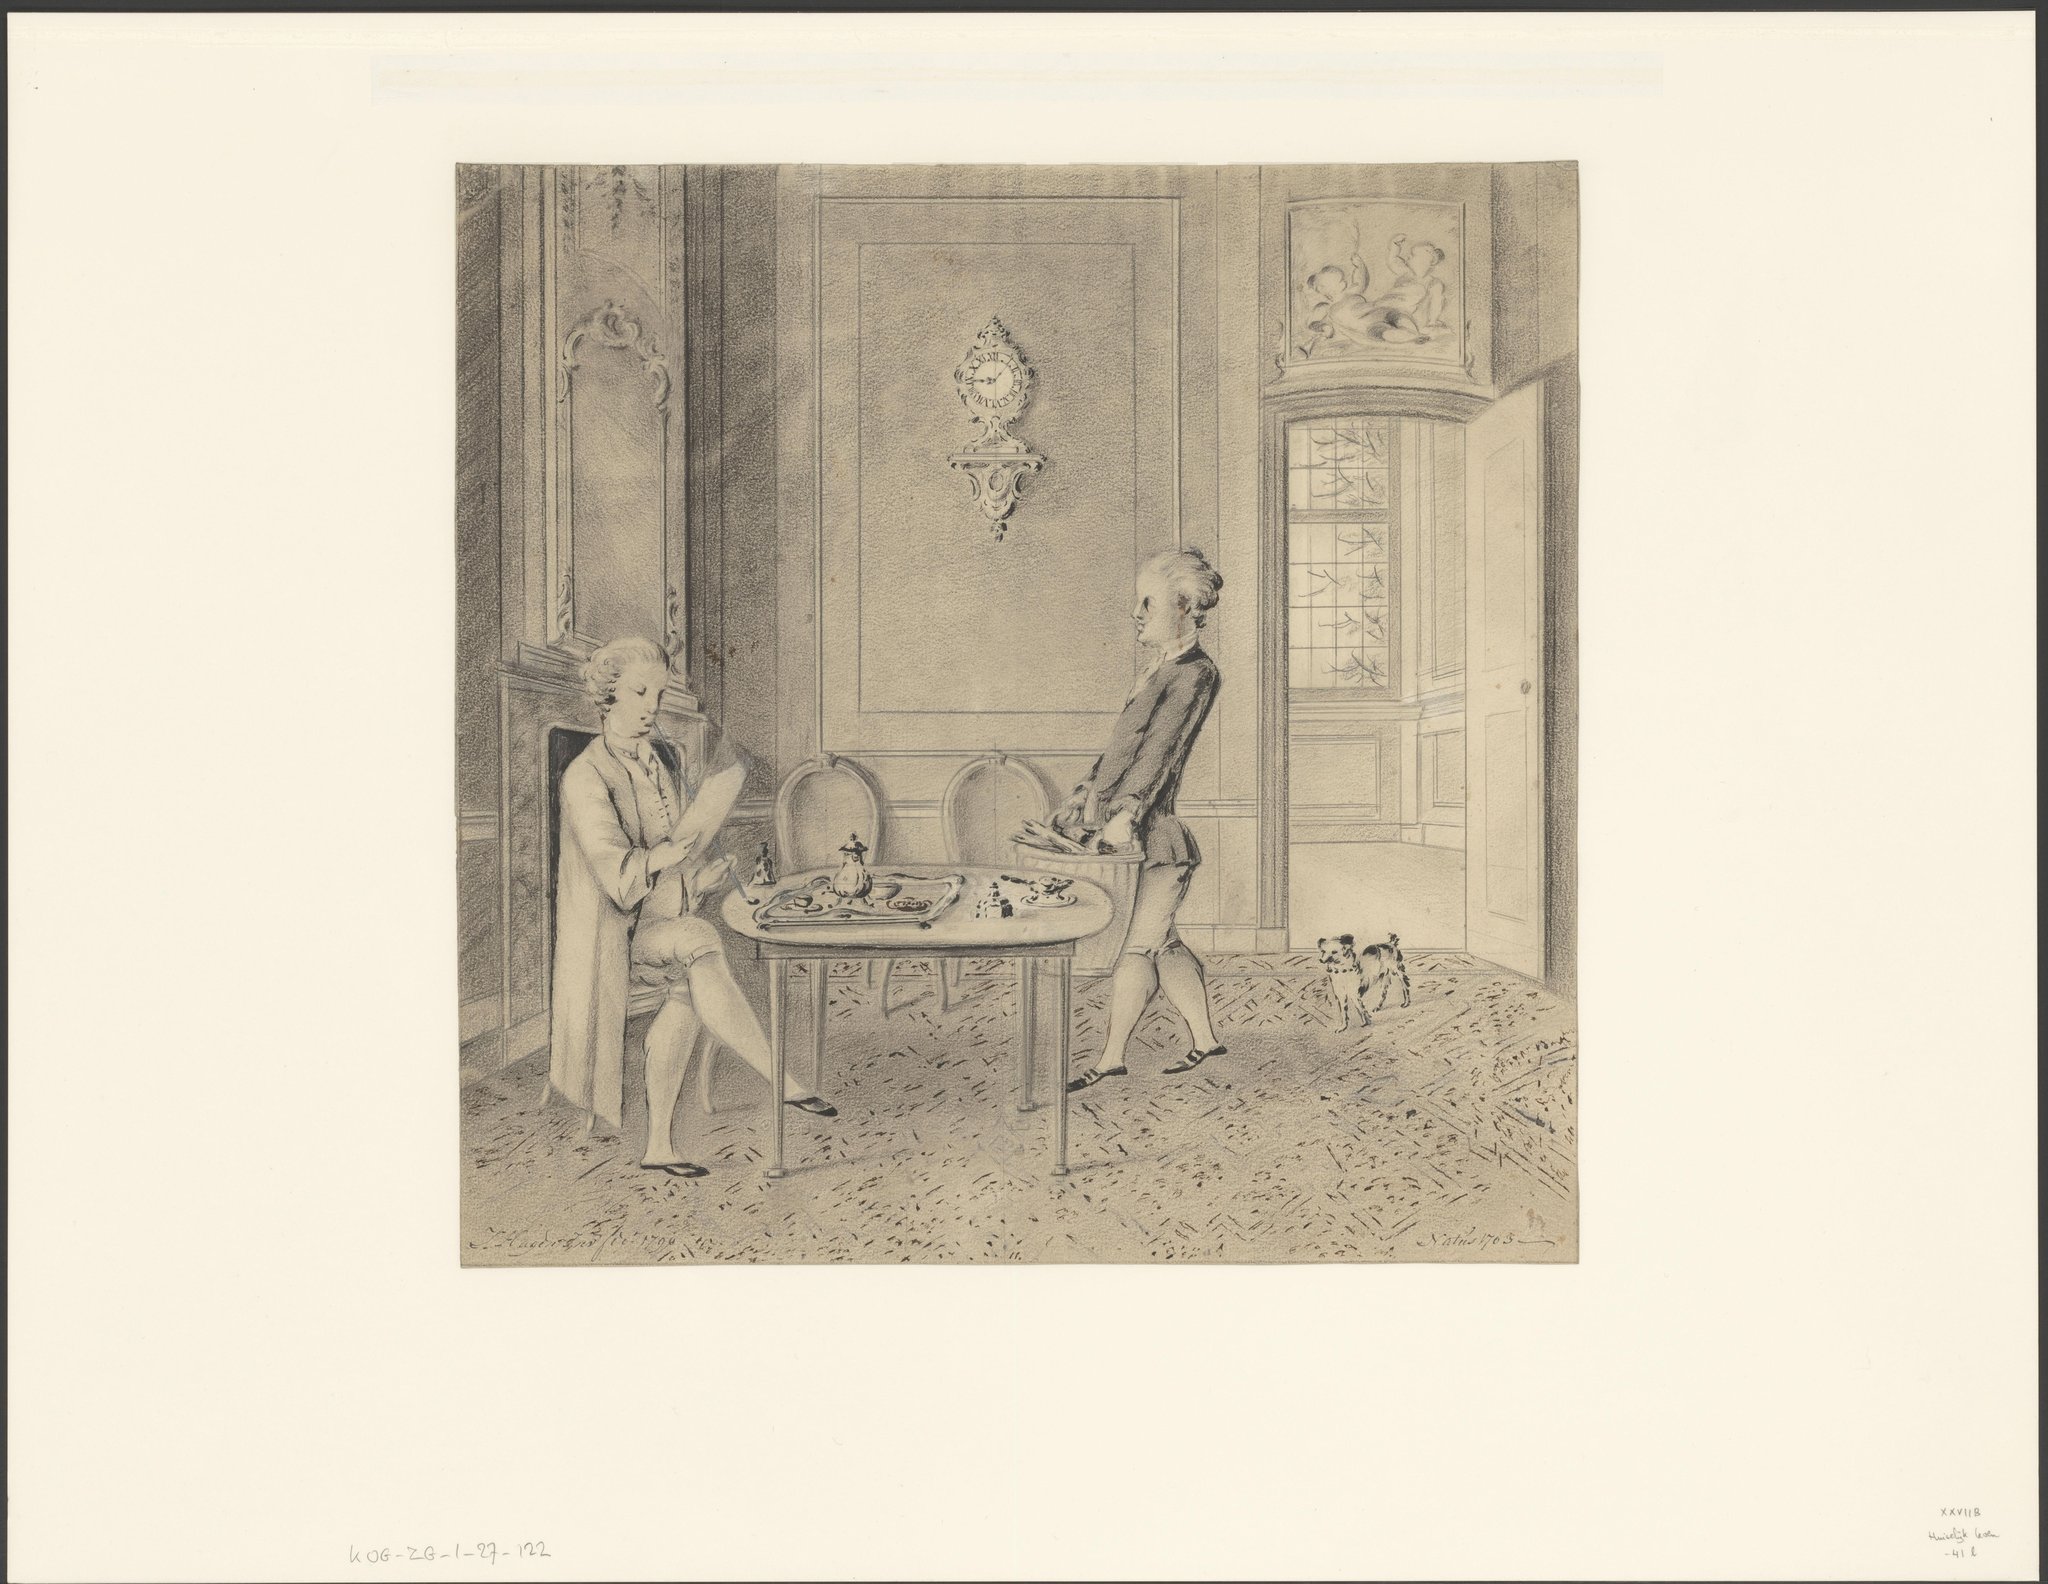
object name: drawing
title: Huiselijke taferelen door Jacob Hagen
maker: jacob hagen (ii)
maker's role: draughtsman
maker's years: 1703-1791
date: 1799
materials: chalk, ink, paper, pencil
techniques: brush, pen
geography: netherlands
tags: pipe ~ tobacco, communal rooms, writing and letters, house personnel, servants, dog